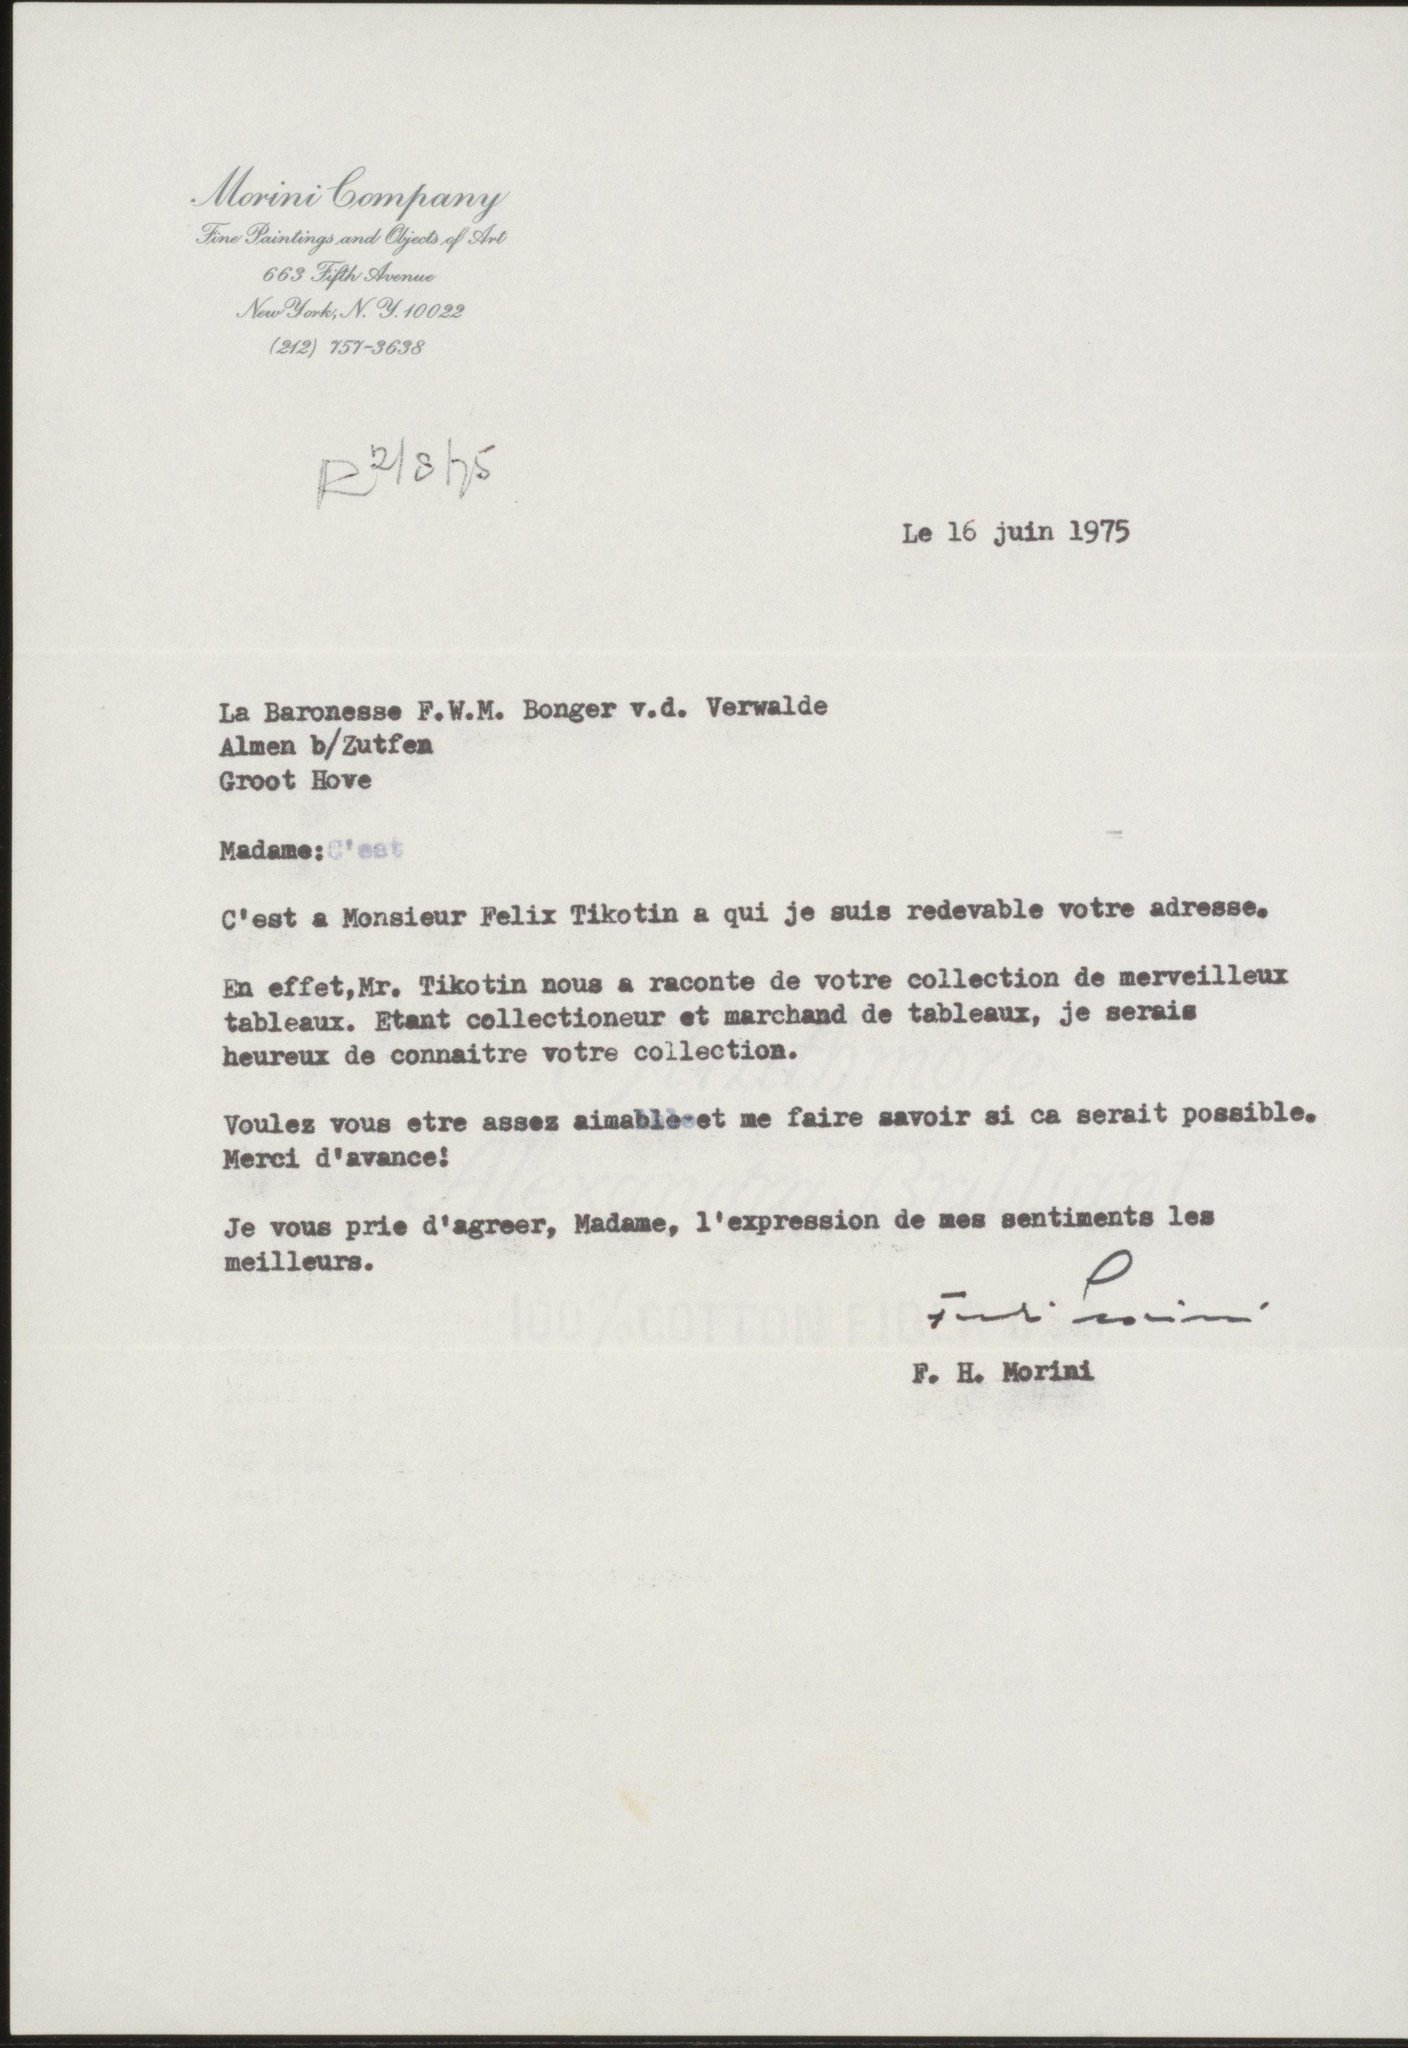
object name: letter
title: Brief aan Françoise W.M. Bonger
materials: ink, paper, pencil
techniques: pen, printing, typewriting, writing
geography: new york city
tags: françoise w.m. bonger, art trade, art shop, painting (including book-illumination, miniature-painting), art collecting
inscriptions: watermark